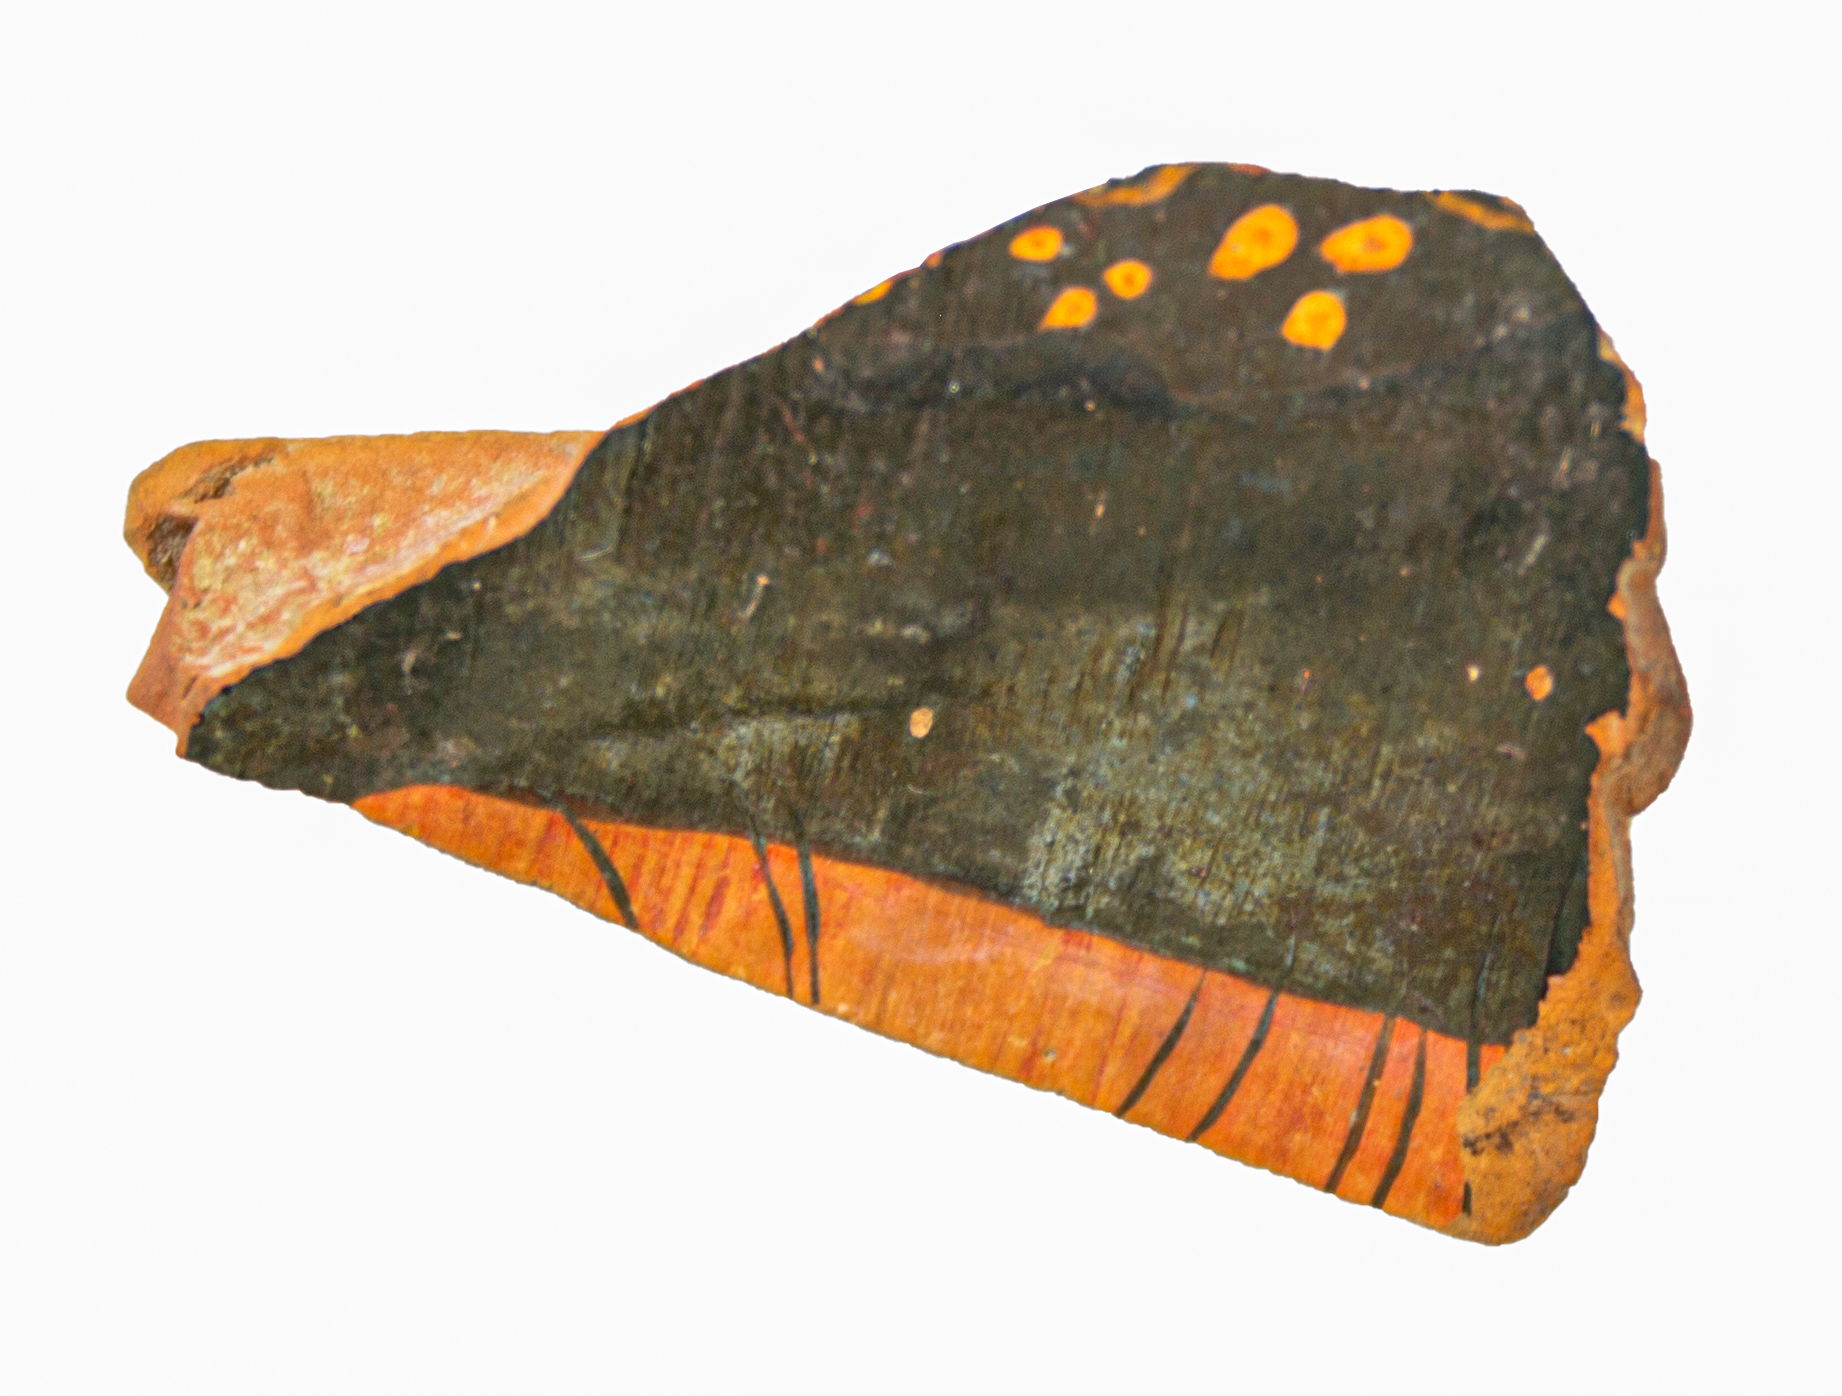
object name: volute krater fragment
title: Volute-krater fragment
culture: greek, south italian, apulian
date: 400-301 BCE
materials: terracotta